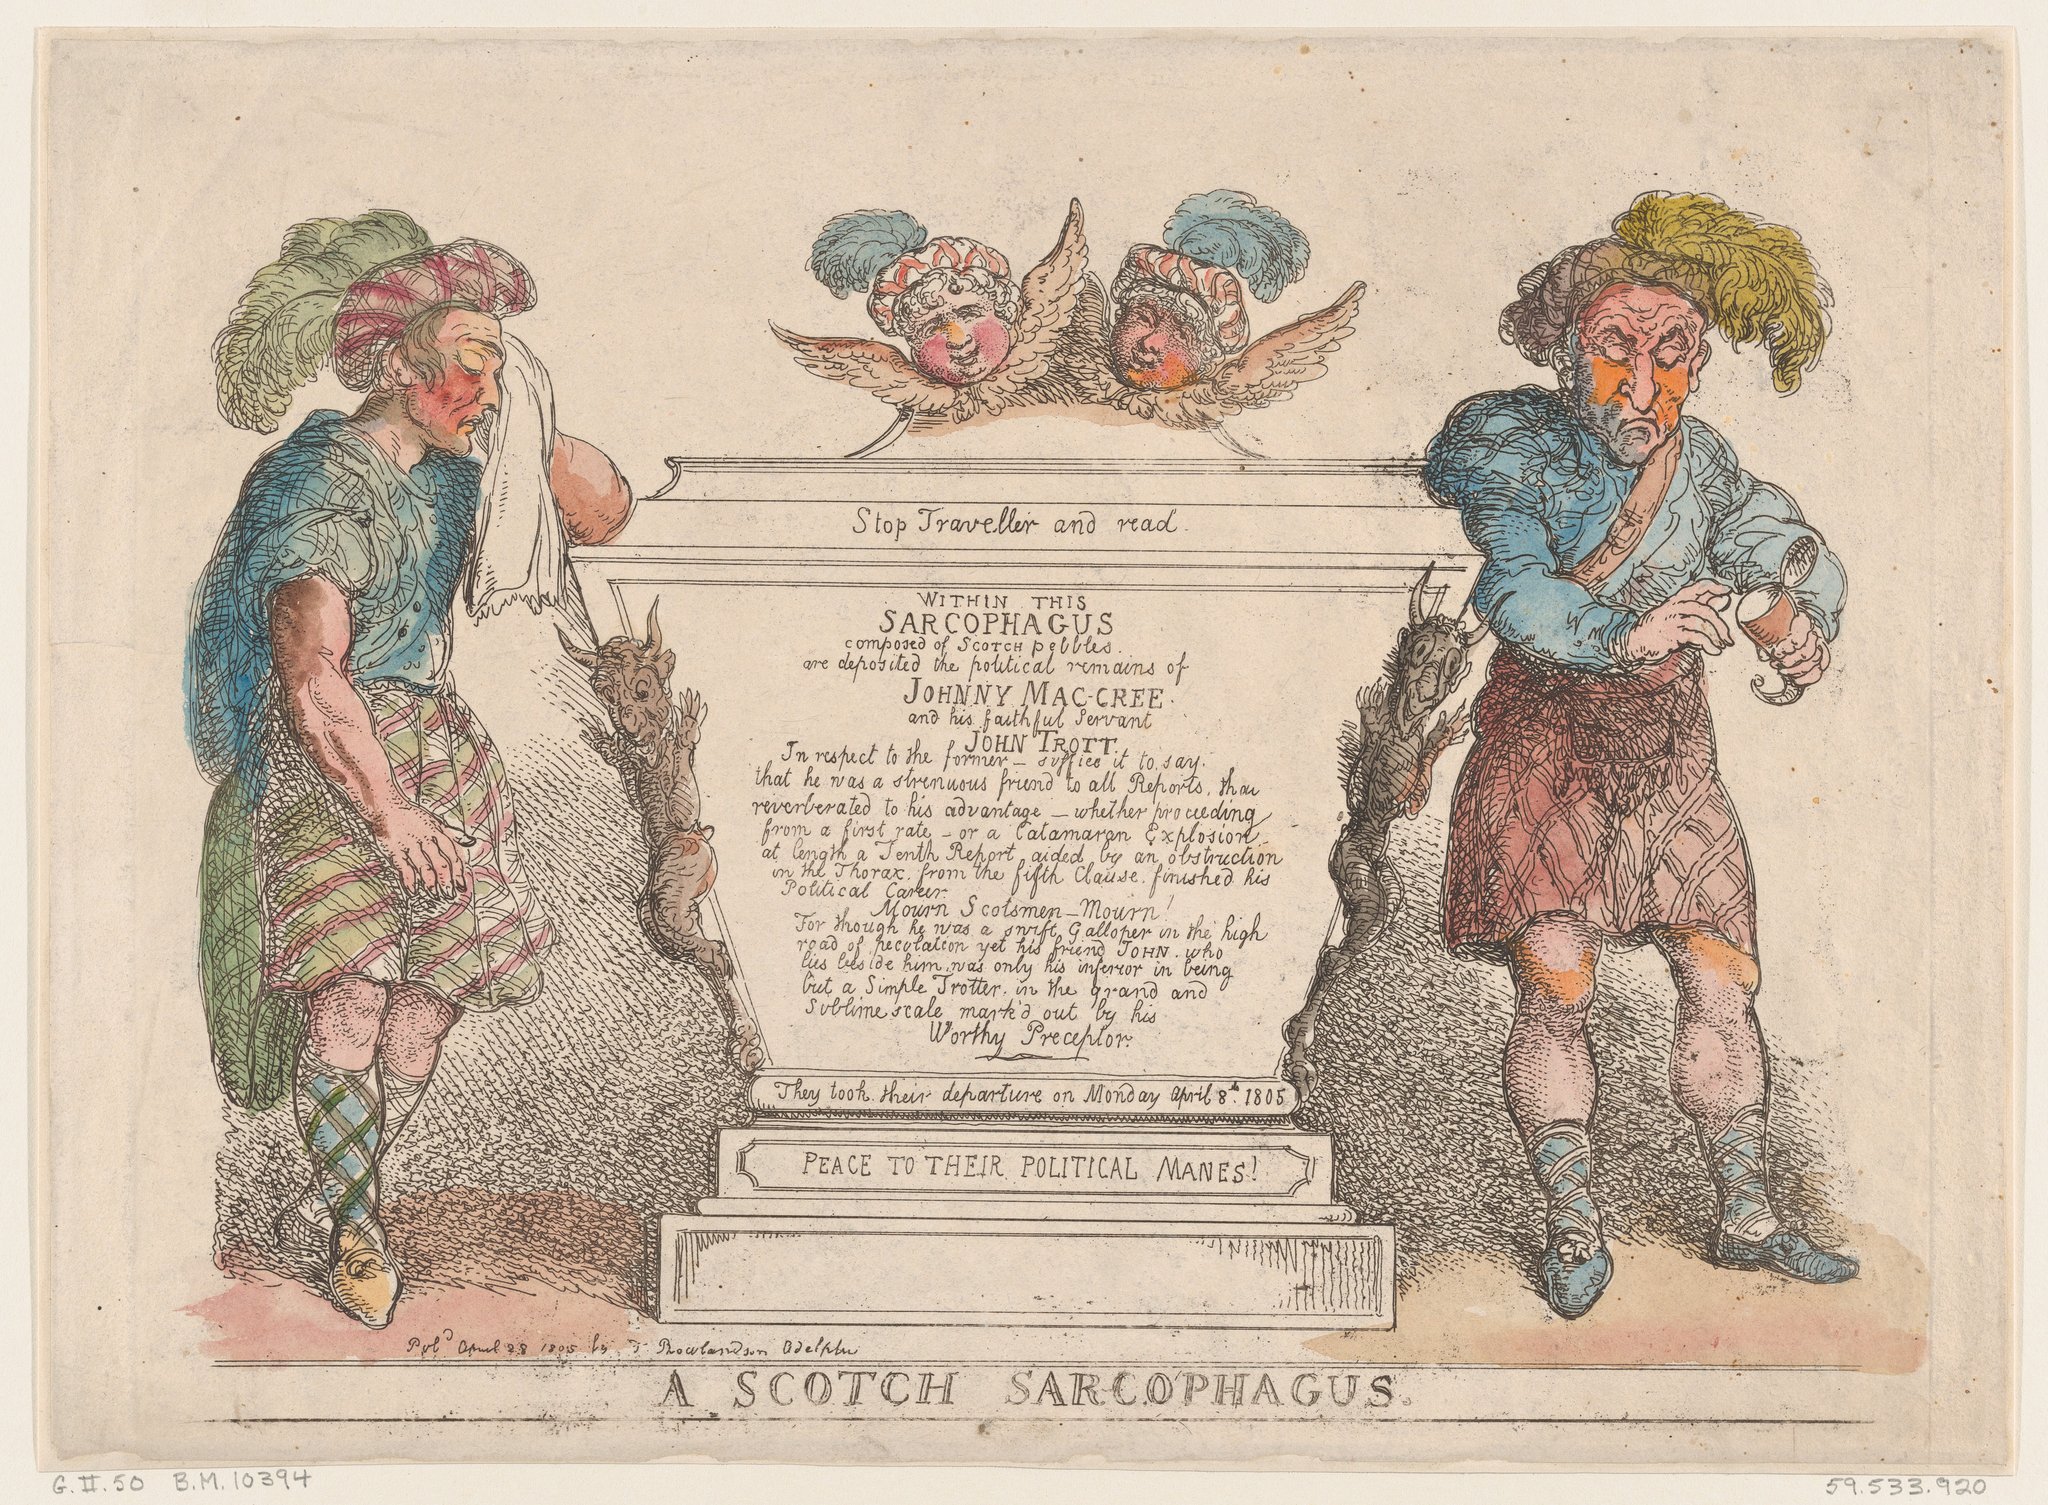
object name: print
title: A Scotch Sarcophagus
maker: thomas rowlandson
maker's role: artist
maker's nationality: british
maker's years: 1757-1827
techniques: etching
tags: satire,men,sarcophagus